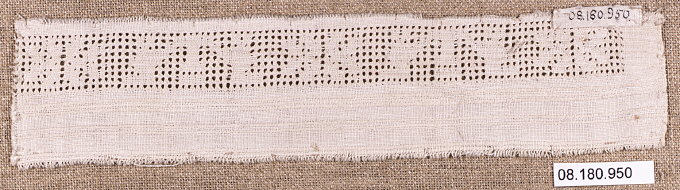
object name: band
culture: peruvian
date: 1701-1800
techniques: embroidery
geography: peru